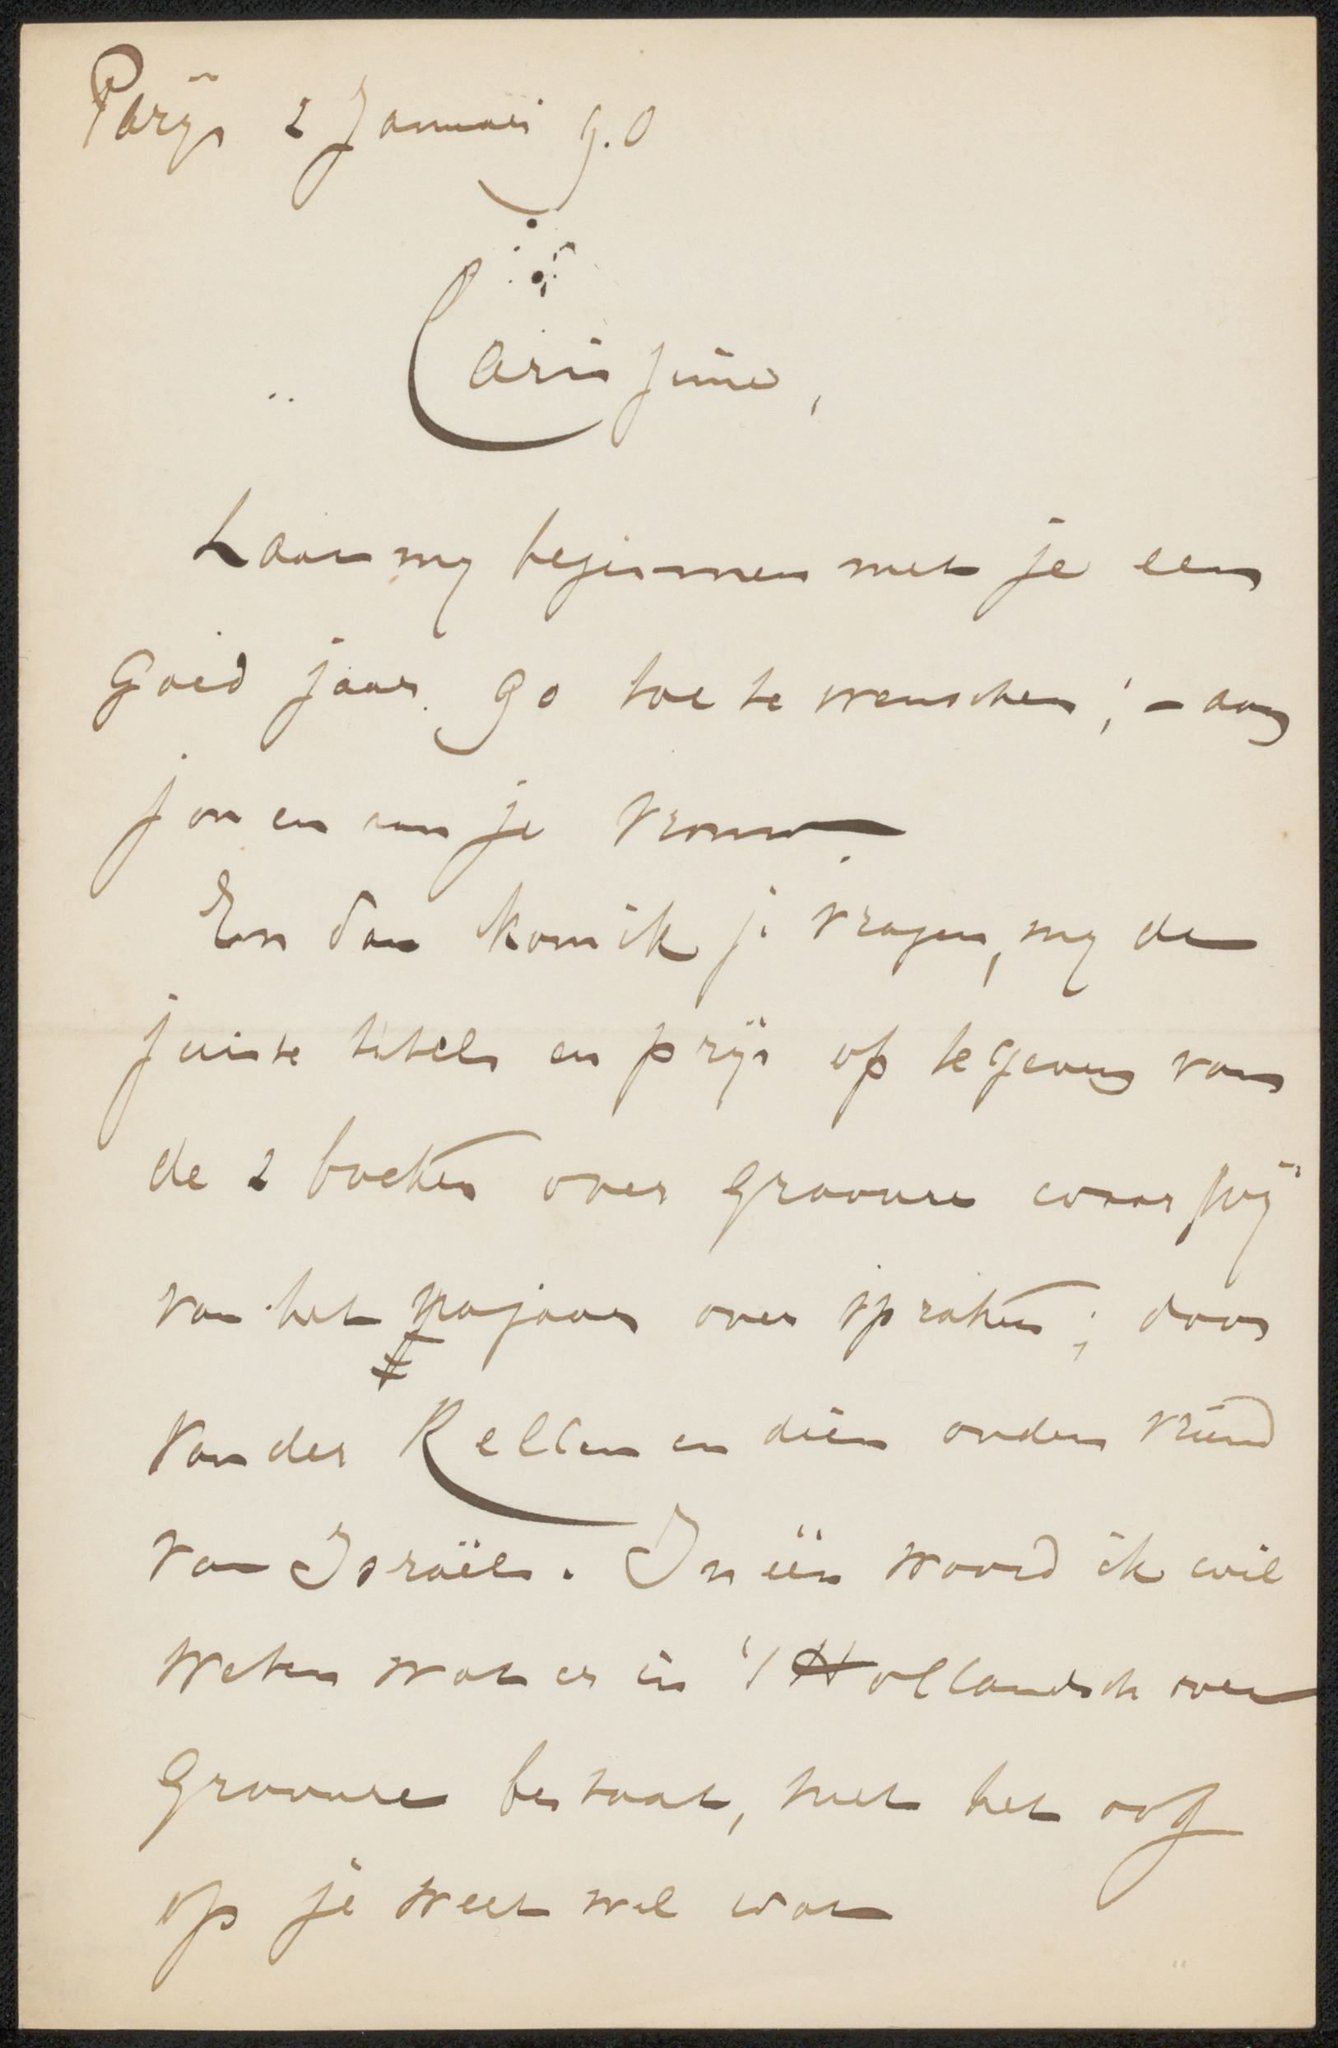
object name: letter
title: Brief aan Philip Zilcken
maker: adriaan pit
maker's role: print maker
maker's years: 1860-1944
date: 1890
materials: ink, paper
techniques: pen, writing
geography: paris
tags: painter, jozef israëls, print maker, draughtsman, johan philip van der kellen, philip zilcken, the graphic arts, money, printed matter, belgium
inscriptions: collector's mark: ‘RPK’